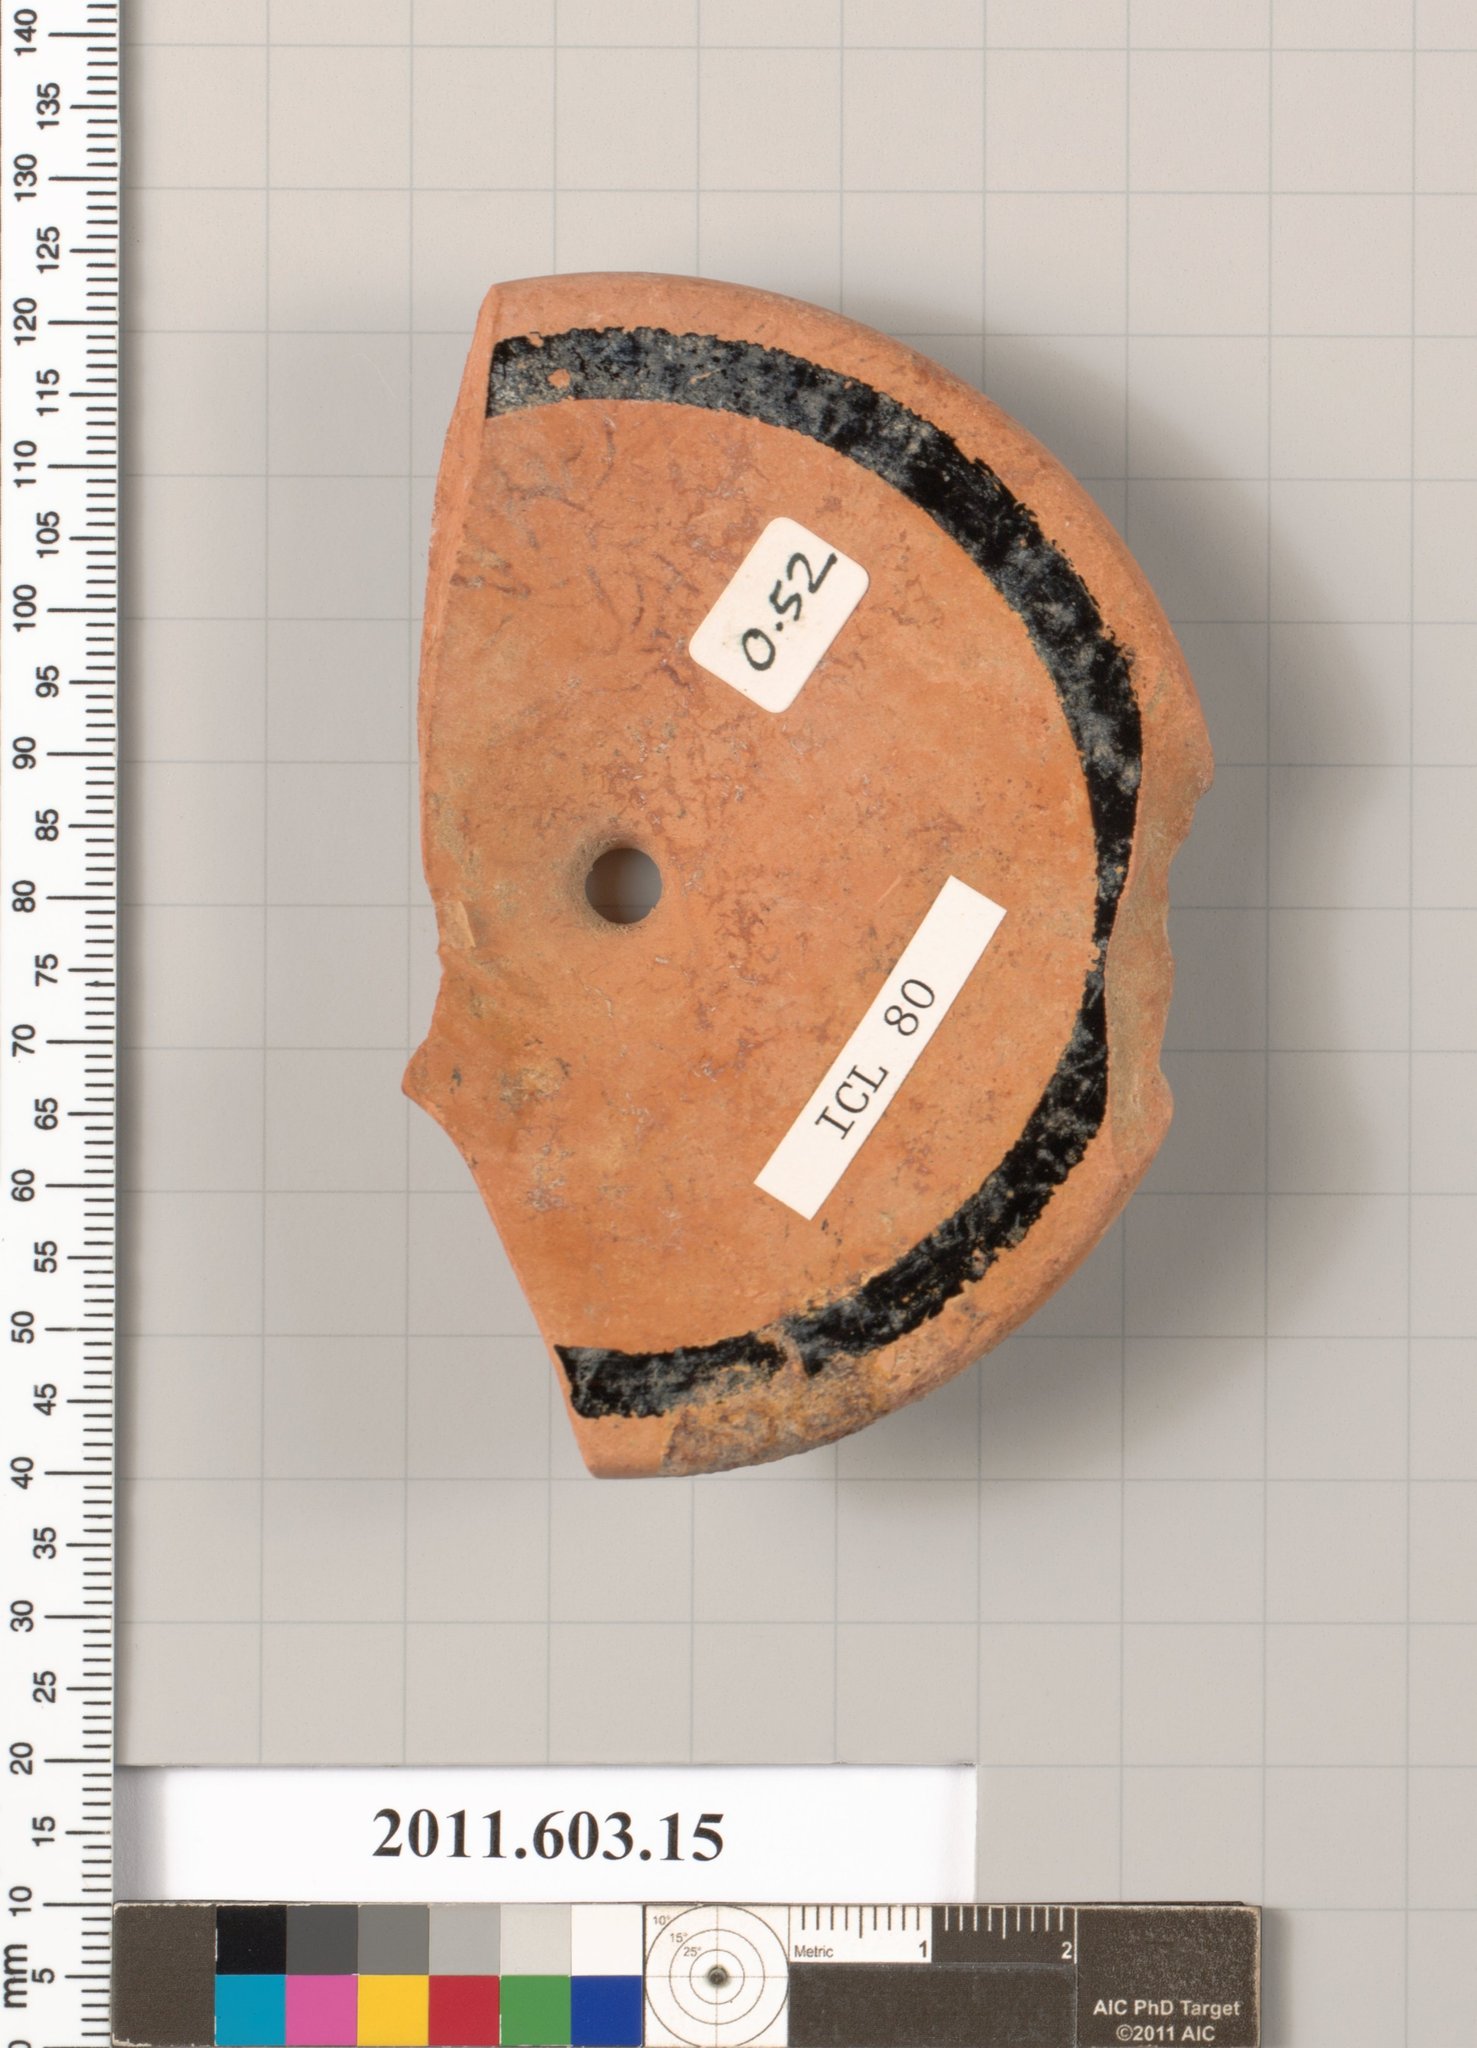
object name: kylix fragment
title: Fragment of a terracotta kylix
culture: greek, attic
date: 500-401 BCE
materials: terracotta